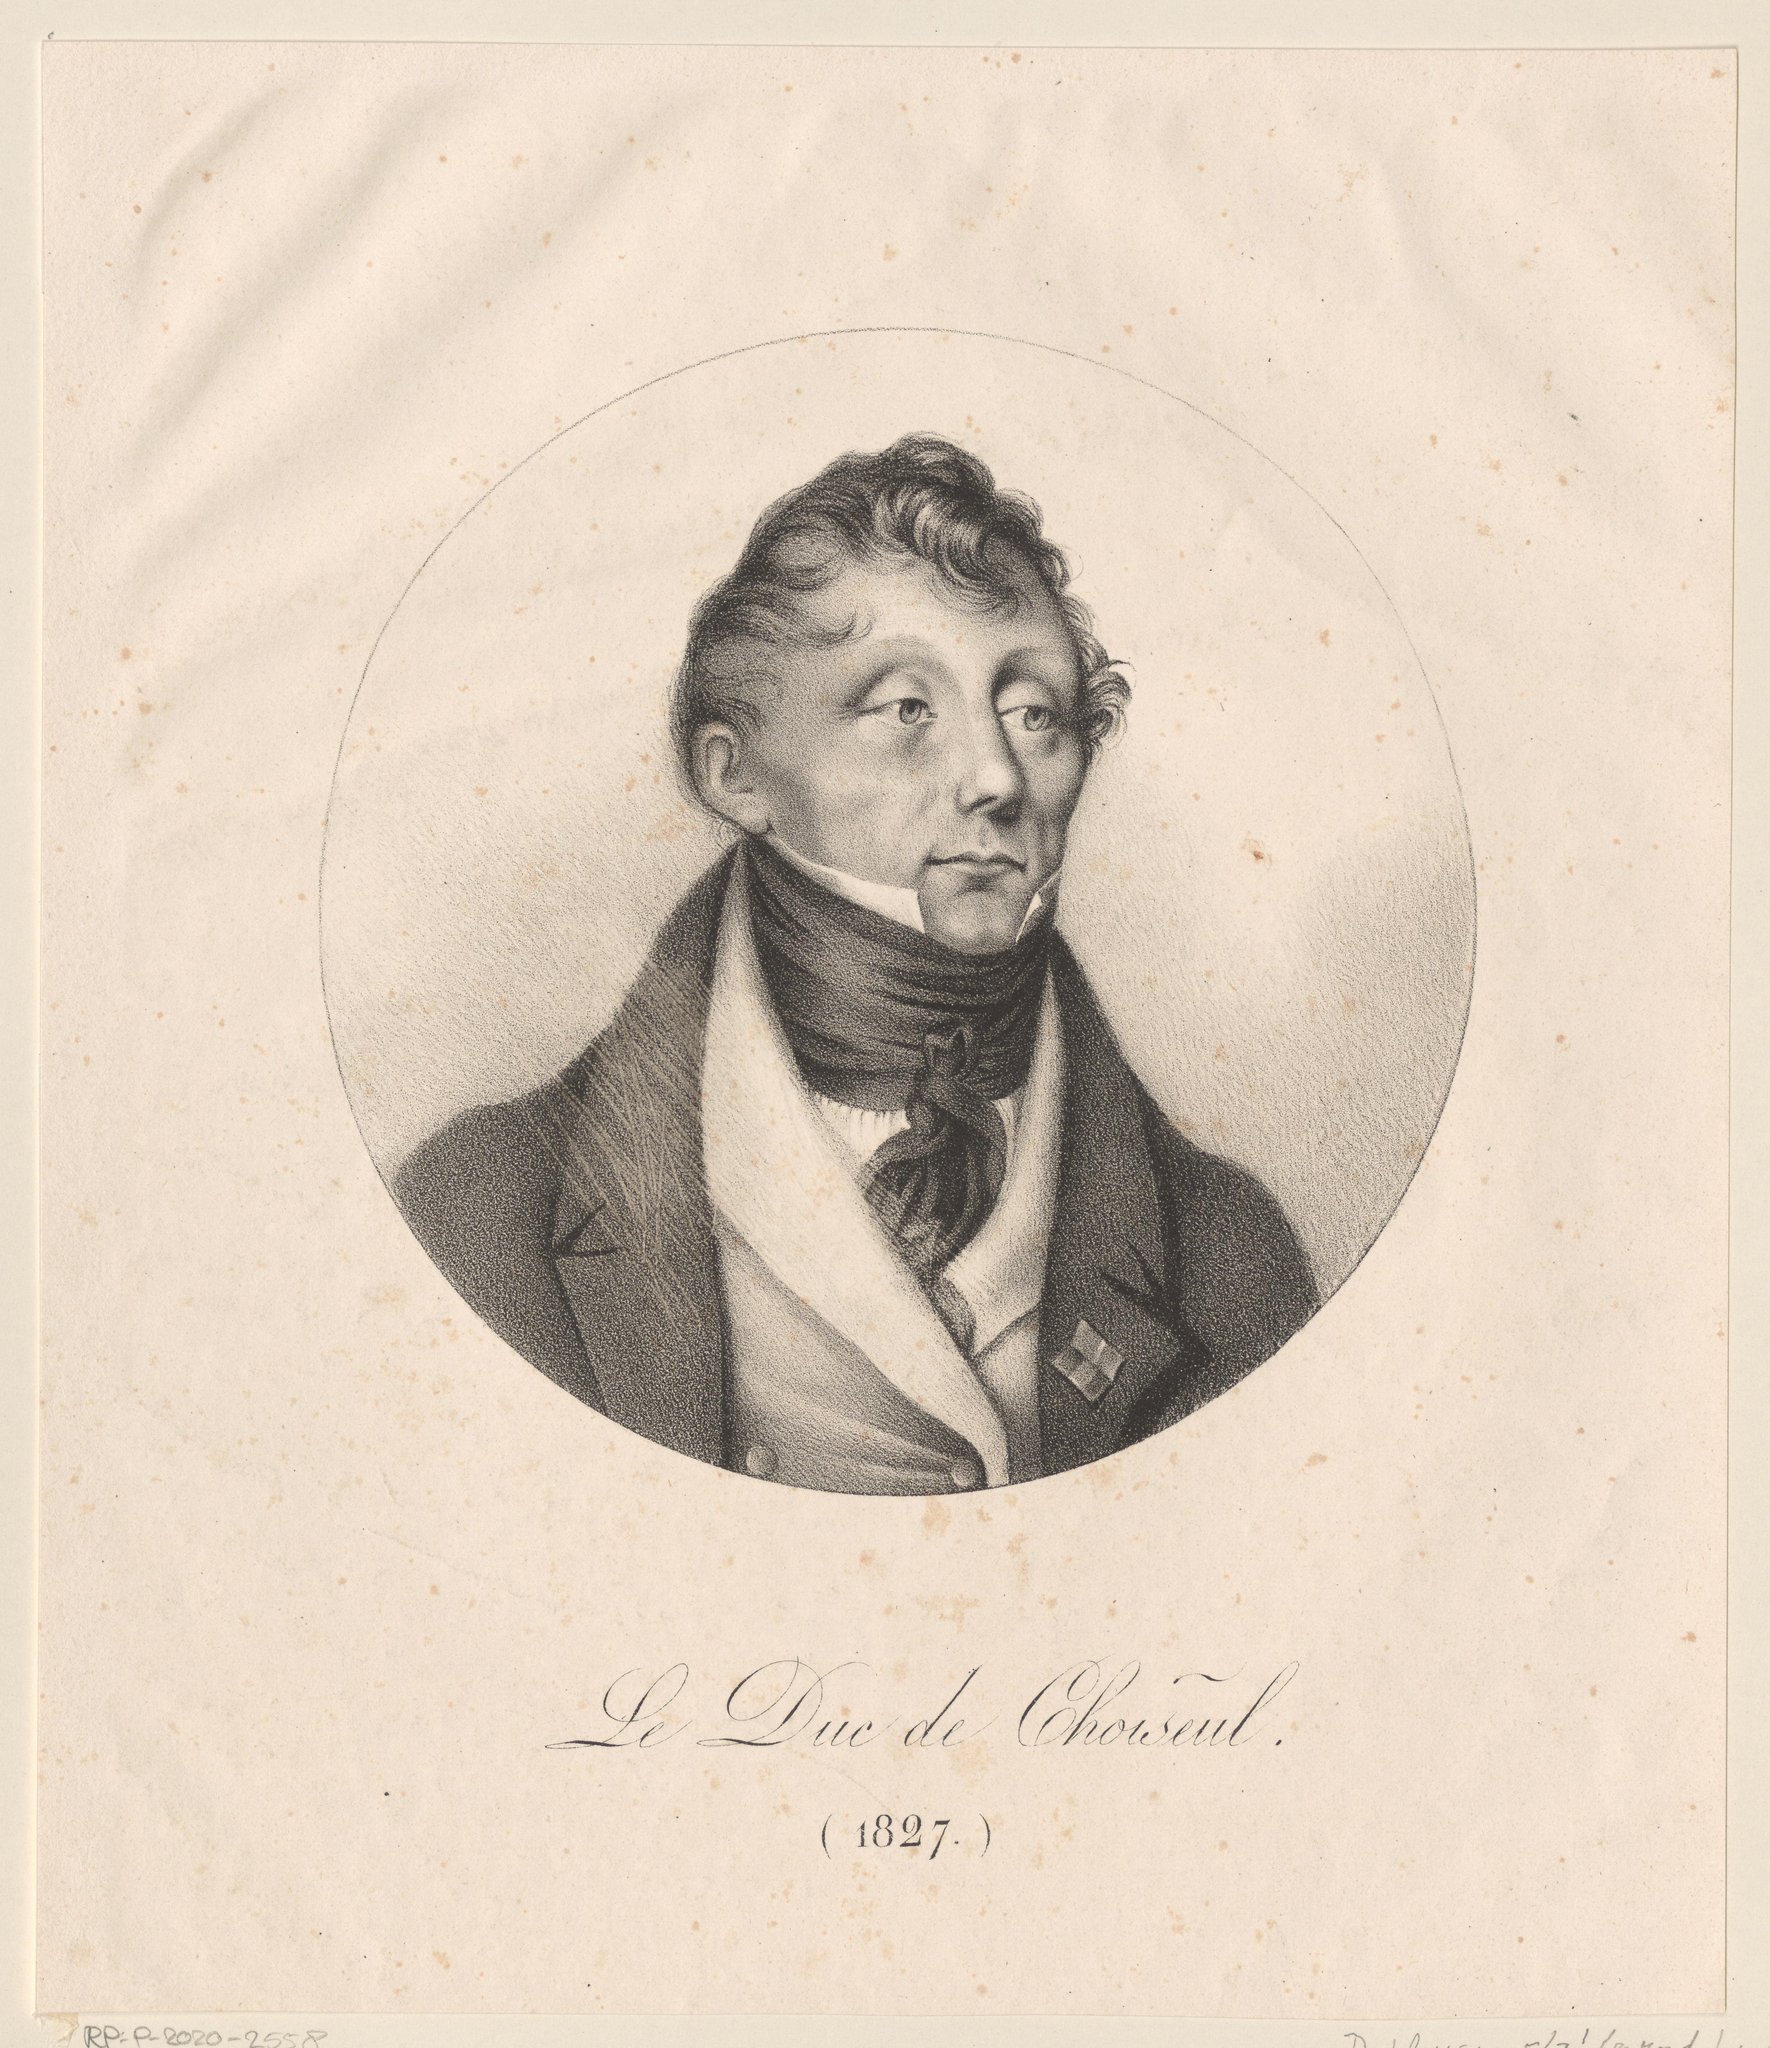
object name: print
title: Portret van Claude-Antoine-Gabriel de Choiseul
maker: Anonymous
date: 1827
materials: paper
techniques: lithograph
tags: paris, historical persons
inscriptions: date